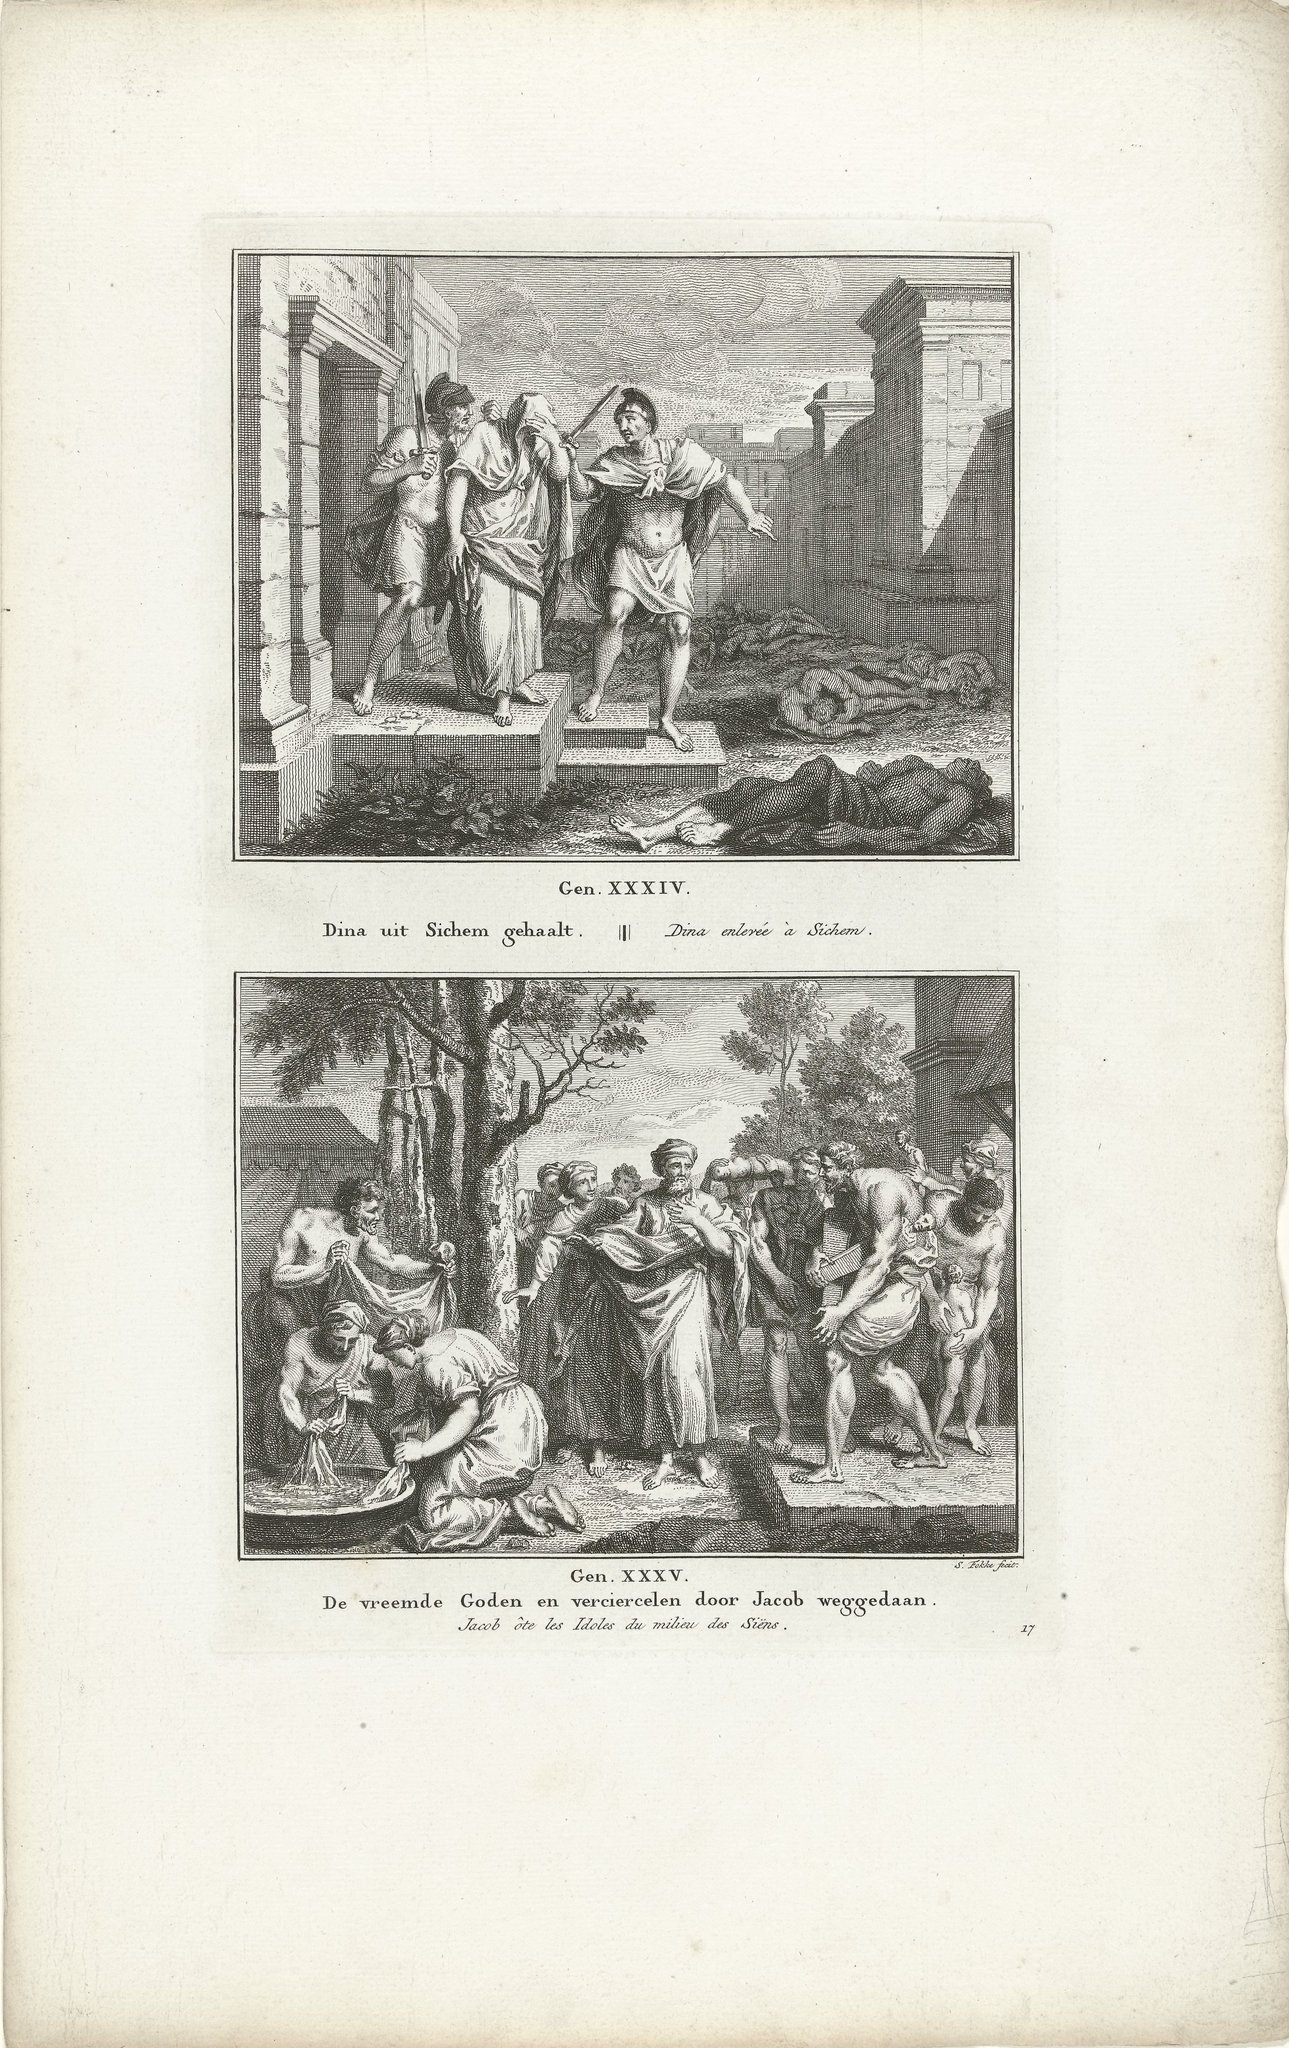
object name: print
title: Dina uit Sichem gehaalt / Dina enlevée à Sichem De vreemde Goden en verciercelen door Jacob weggedaan / Jacob ôte les Idoles du milieu des Siëns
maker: simon fokke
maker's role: draughtsman, print maker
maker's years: 1712-1784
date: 1791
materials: paper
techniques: etching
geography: amsterdam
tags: jacob purges his house of idols, the rape of dinah by shechem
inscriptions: collector's mark: Lugt 2233, collector's mark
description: Twee Bijbelse voorstellingen uit Gen. 34 en 35. Genummerd rechtsonder: 17.